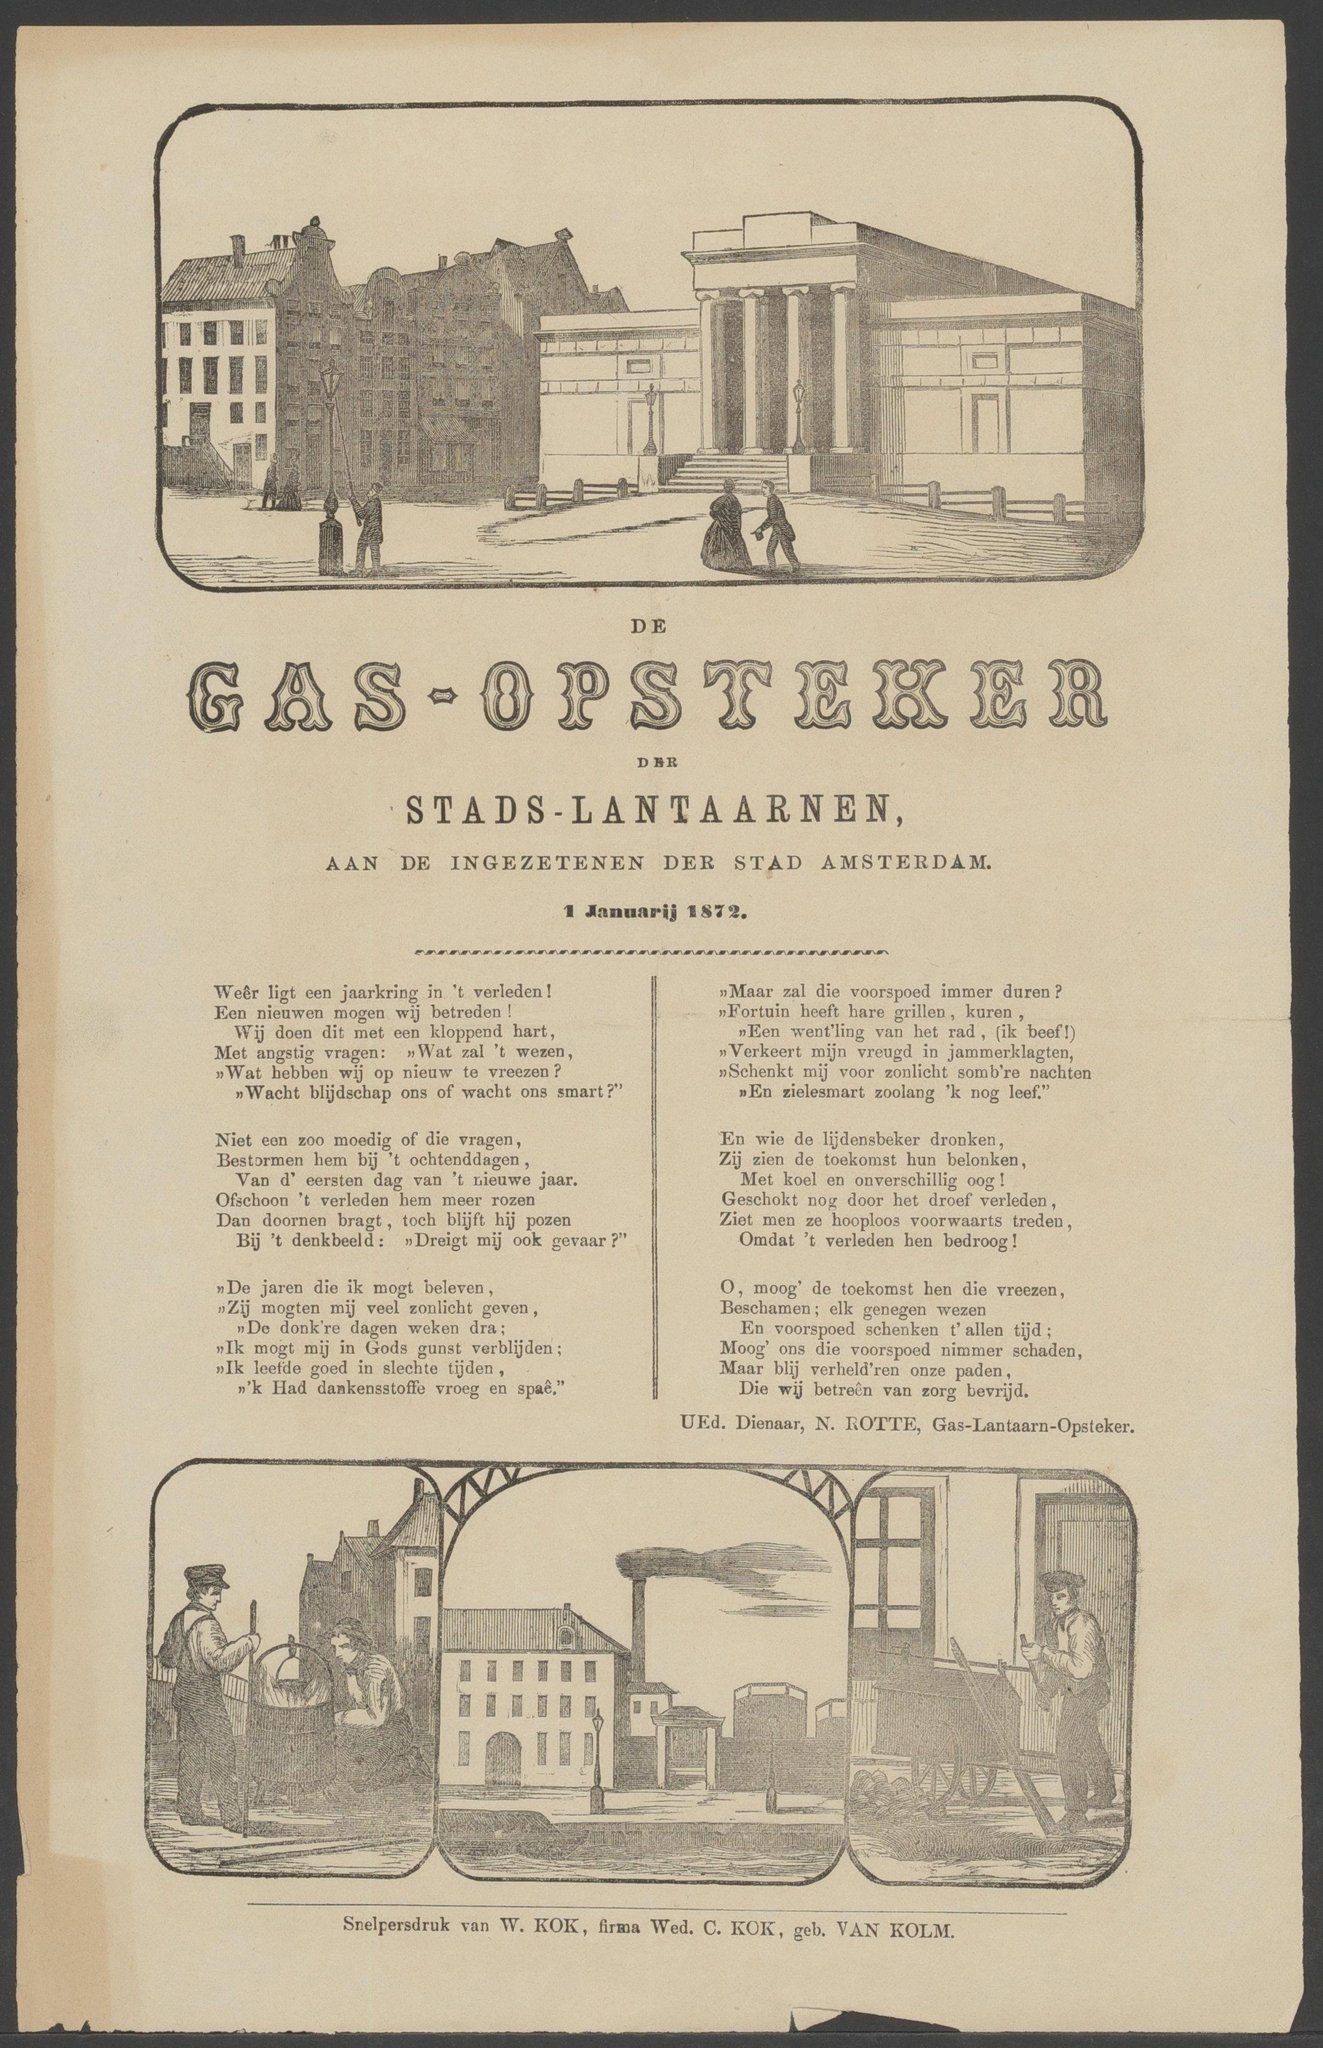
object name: new year card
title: De Gas-opsteker der Stads-lantaarnen, aan de ingezetenen der stad Amsterdam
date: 1871-1872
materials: paper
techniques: letterpress printing, engraving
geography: amsterdam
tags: gas-lamp, gas supply, digging (industrial process), street lighting, amsterdam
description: Nieuwjaarswens van de Amsterdamse gaslantaarnopstekers voor het jaar 1872. Centraal een vers in twee kolommen. Bovenaan de Dam met de beurs van Zocher te Amsterdam. Onderaan de Hollandsche Gasfabriek en twee gasfitters aan het werk. Van de gaslantaarnopsteker: N. Rotte. Onderwerpsrubrieken binnen de Atlas Zeden en Gewoonten: Zeden en gewoonten in engeren zin, Volksleven, Volksbladen, Nieuwjaars- en Kerstwenschen, Amsterdam.